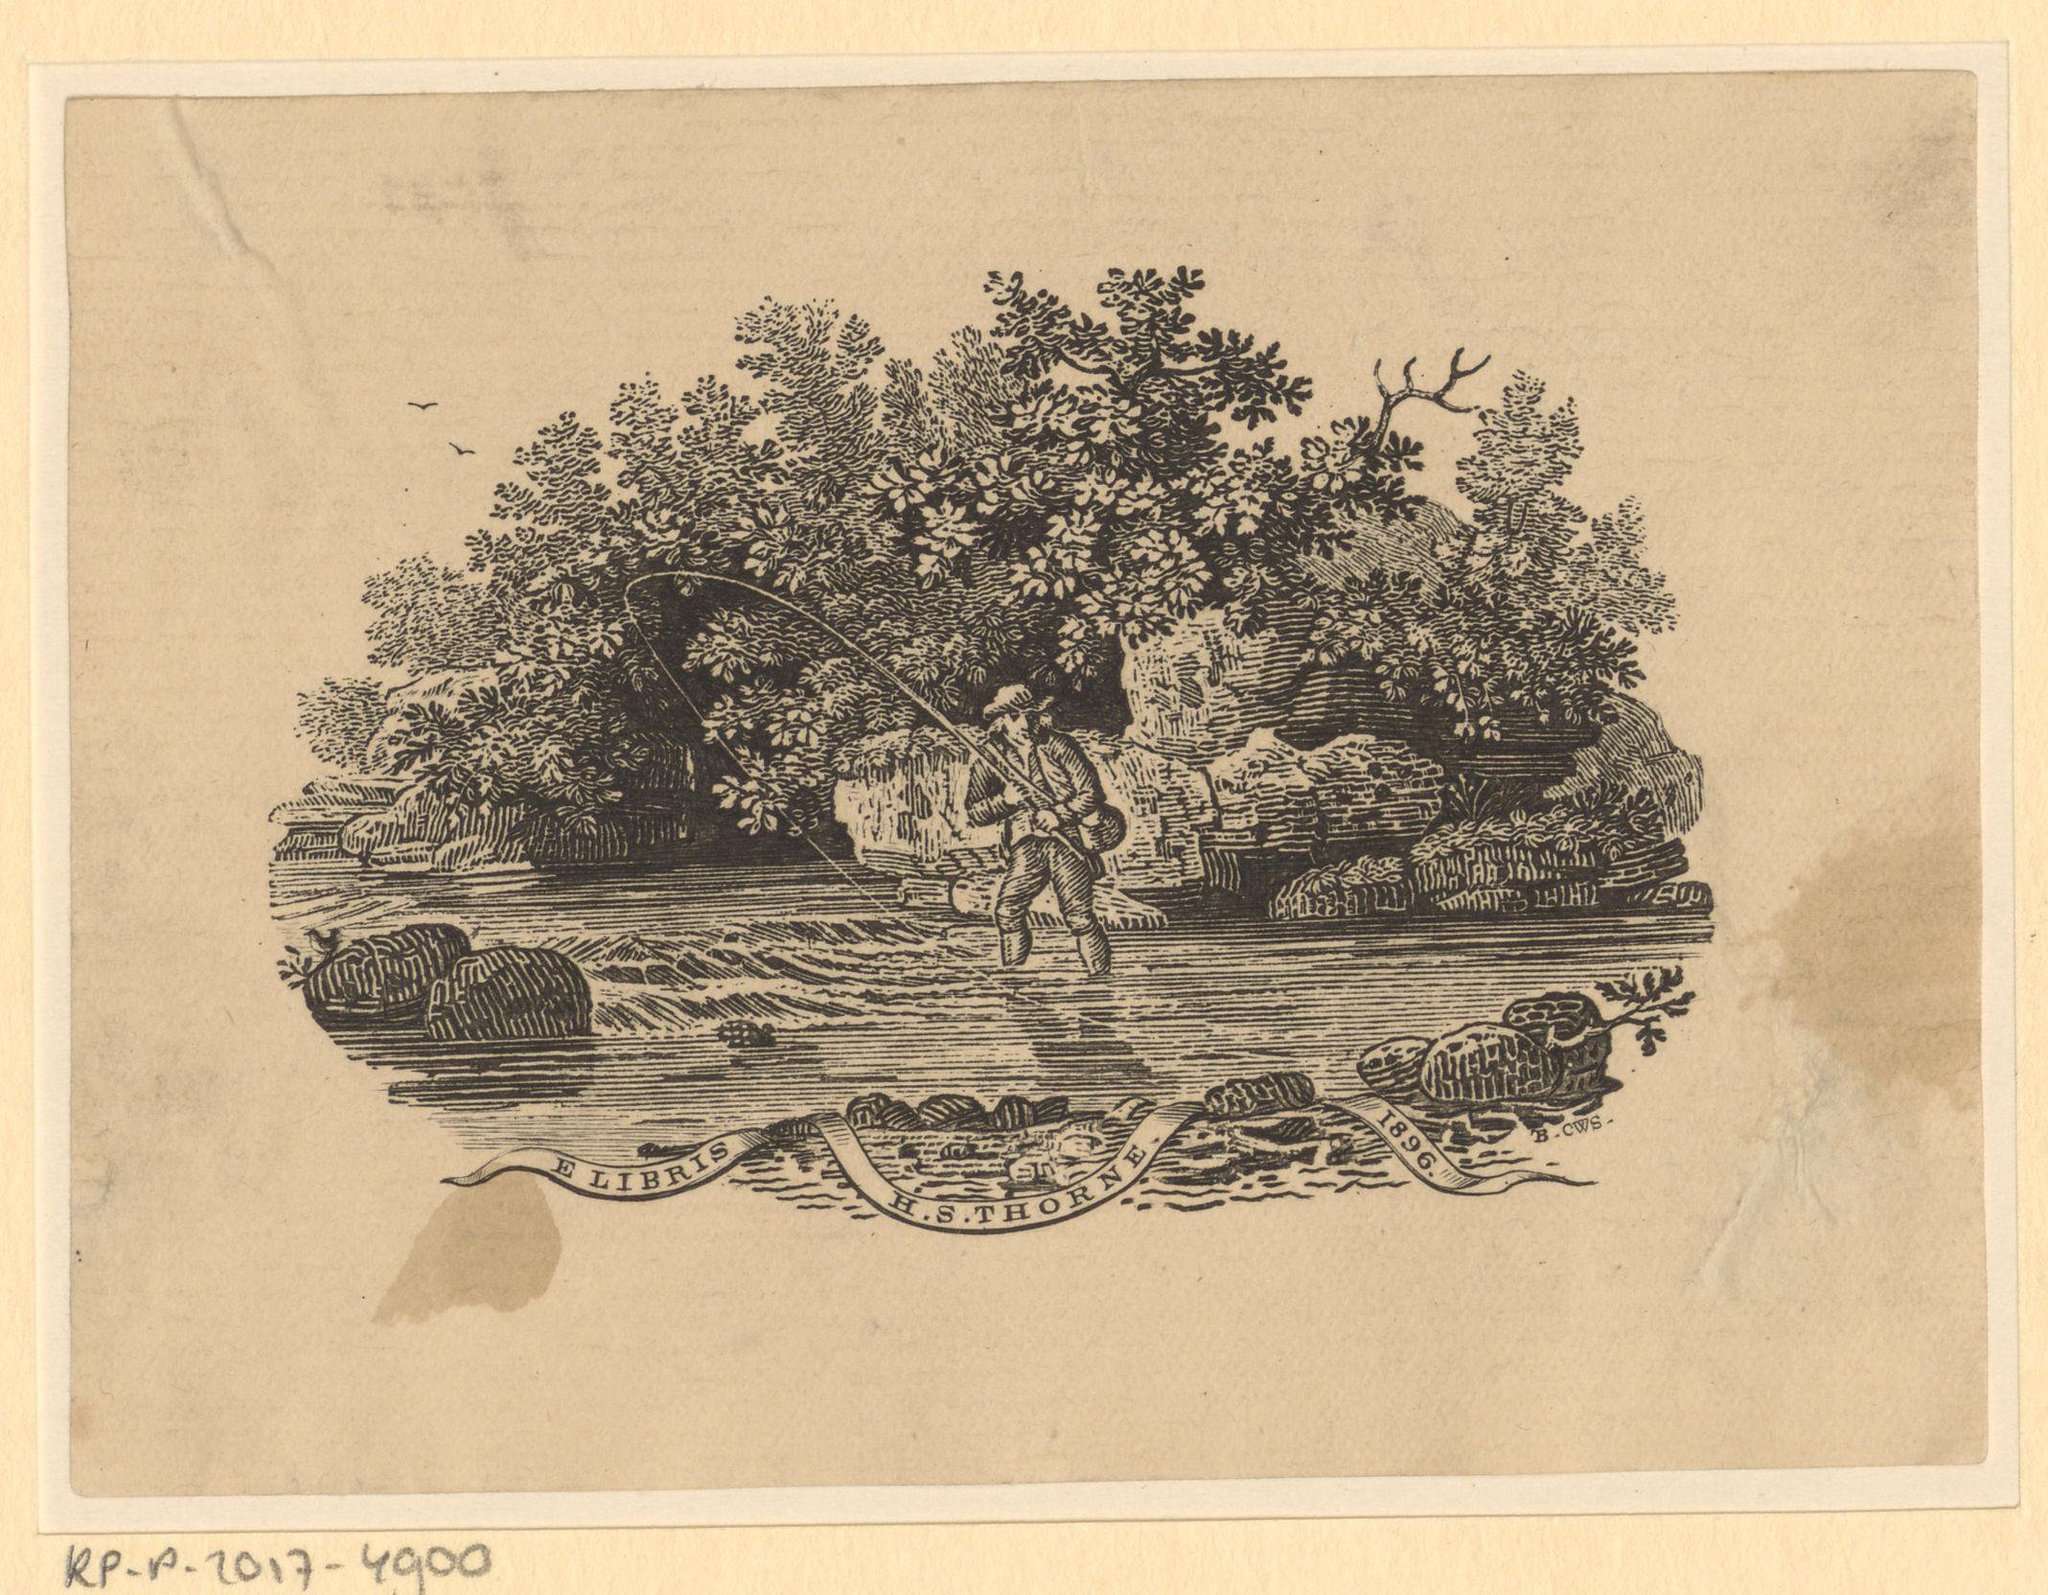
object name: bookplate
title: Ex libris van H.S. Thorne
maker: charles william sherborn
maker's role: print maker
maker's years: 1831-1912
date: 1896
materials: paper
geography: england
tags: trees, brook, angling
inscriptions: date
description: Het schilderij "Vrouw bij het raam" van Johannes Vermeer was aan het eind van de negentiende eeuw in bezit van Joseph. Het bevindt zich tegenwoordig in The Frick Collection, New York.